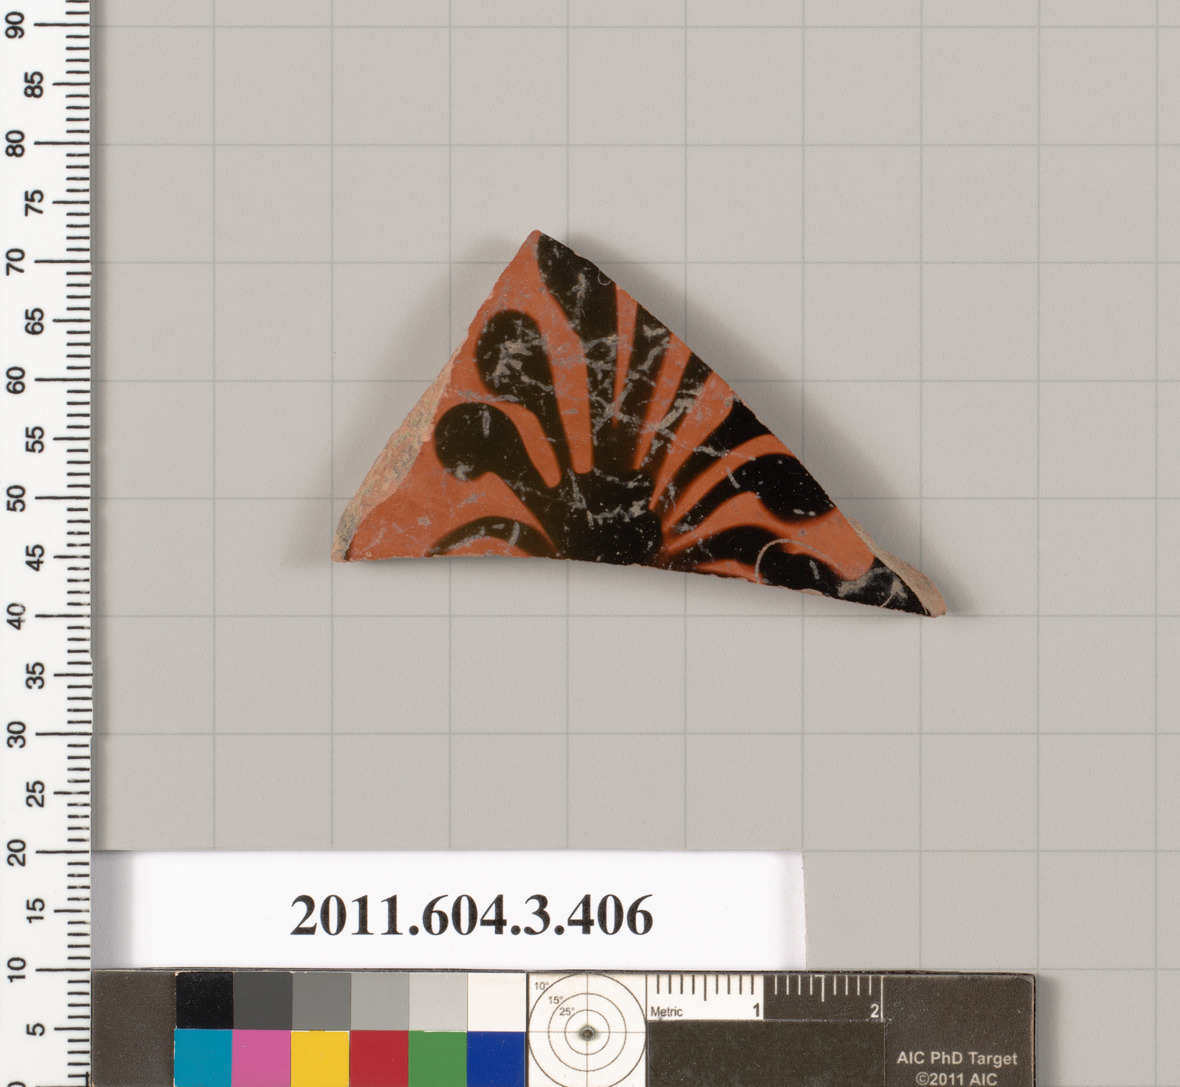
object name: neck amphora fragment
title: Terracotta fragment of a neck-amphora (jar)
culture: greek, attic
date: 500-468 BCE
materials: terracotta